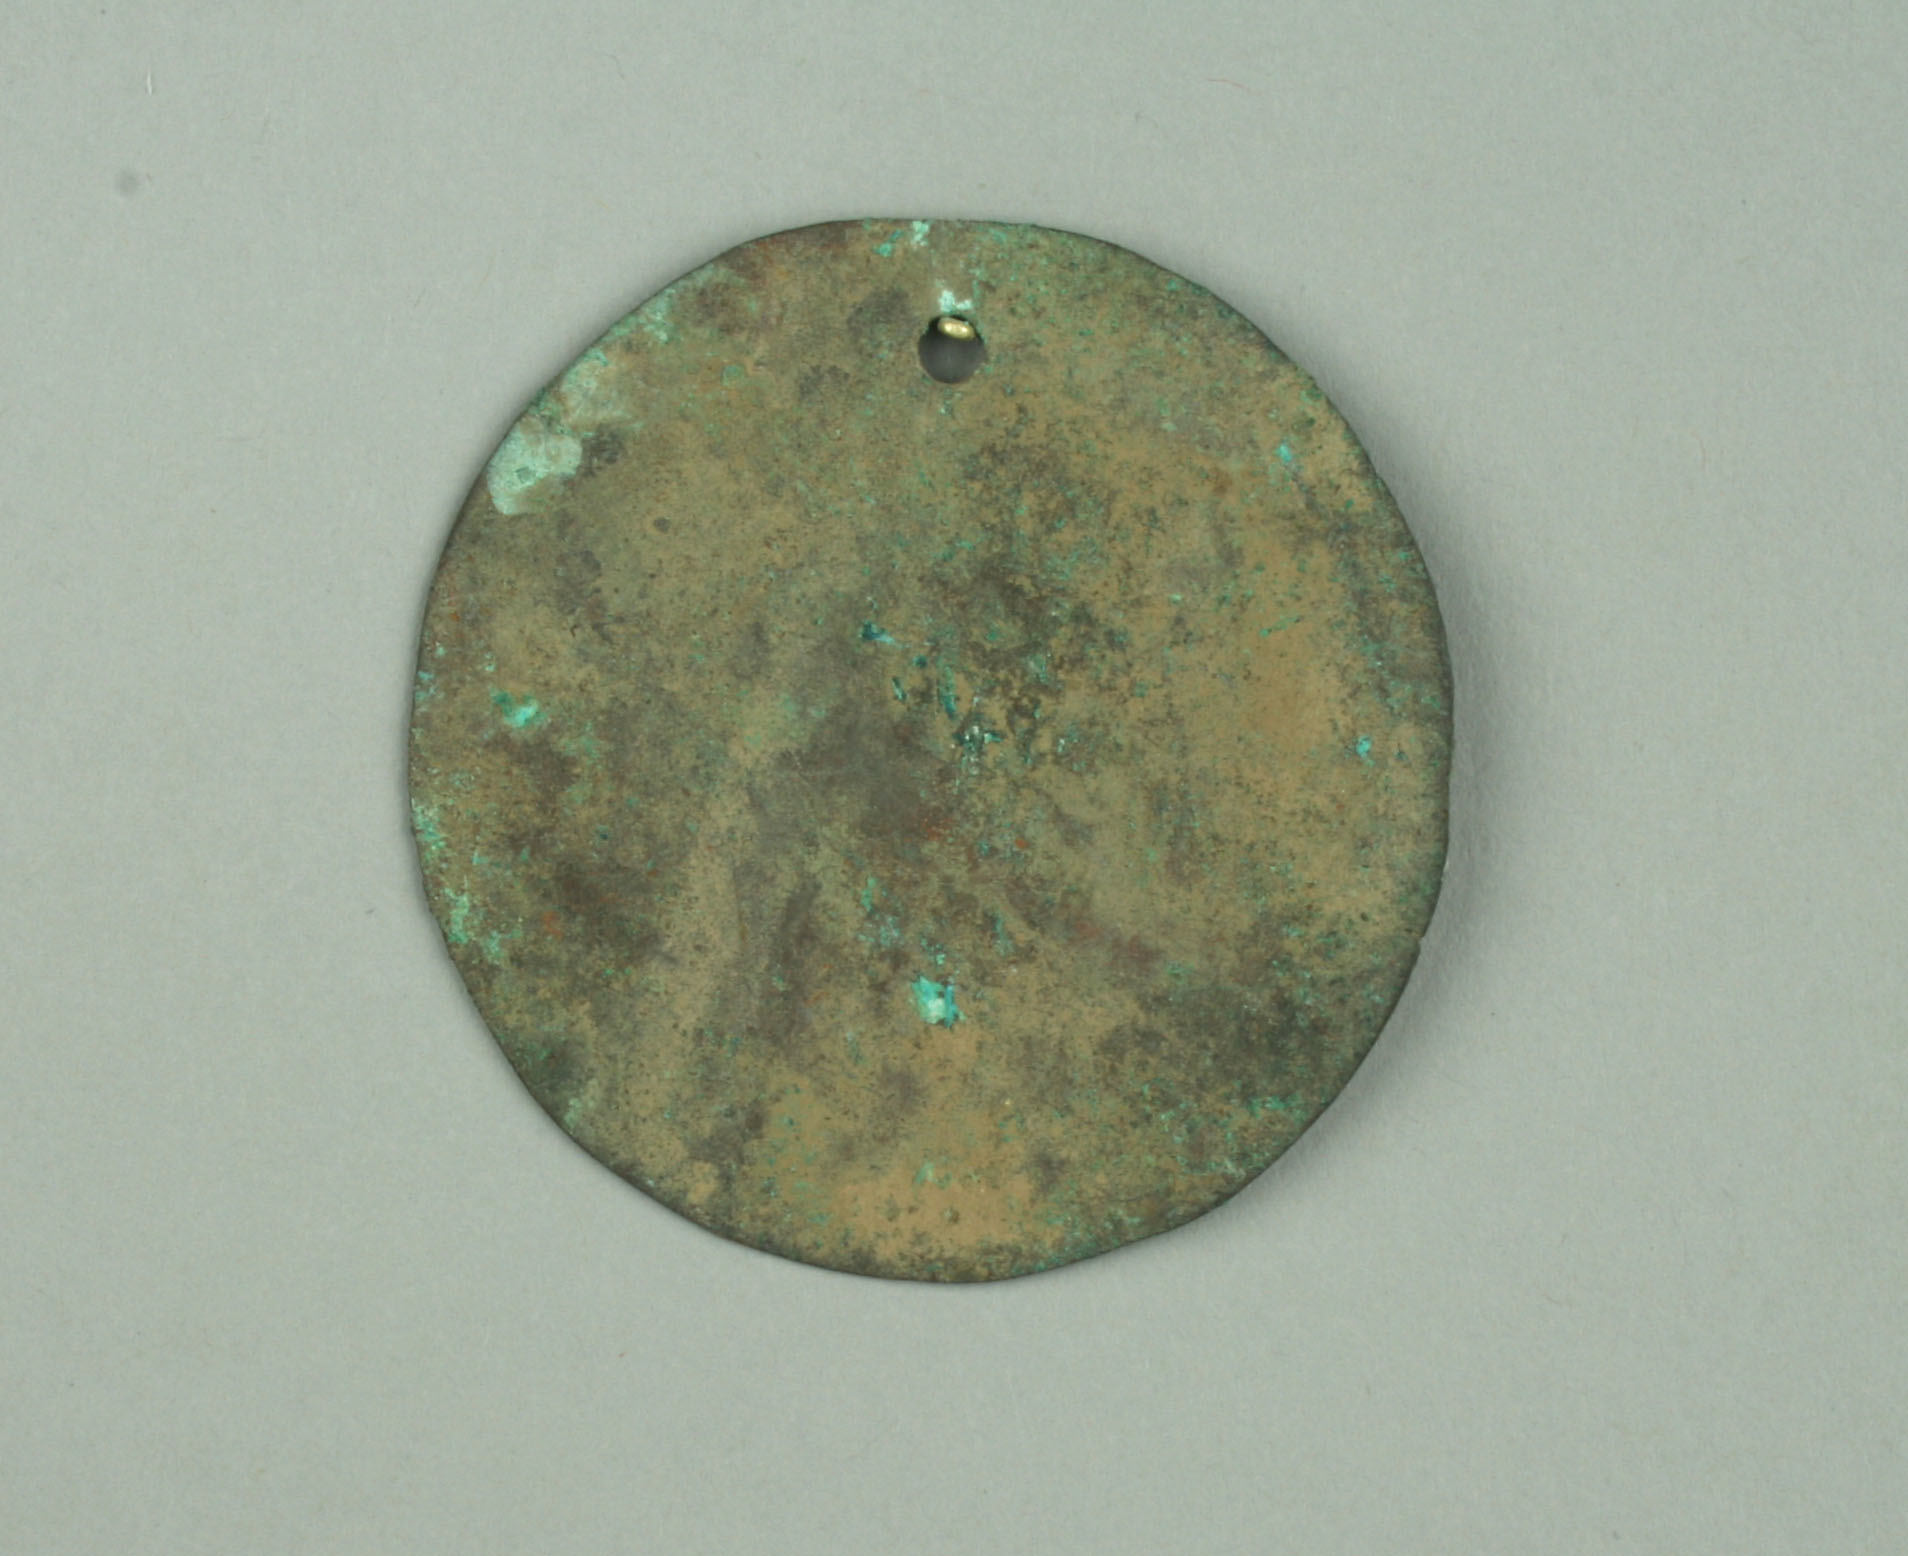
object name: plaque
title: Round Plaque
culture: vicús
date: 300 BCE-200 CE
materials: copper, gilt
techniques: hammering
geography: peru